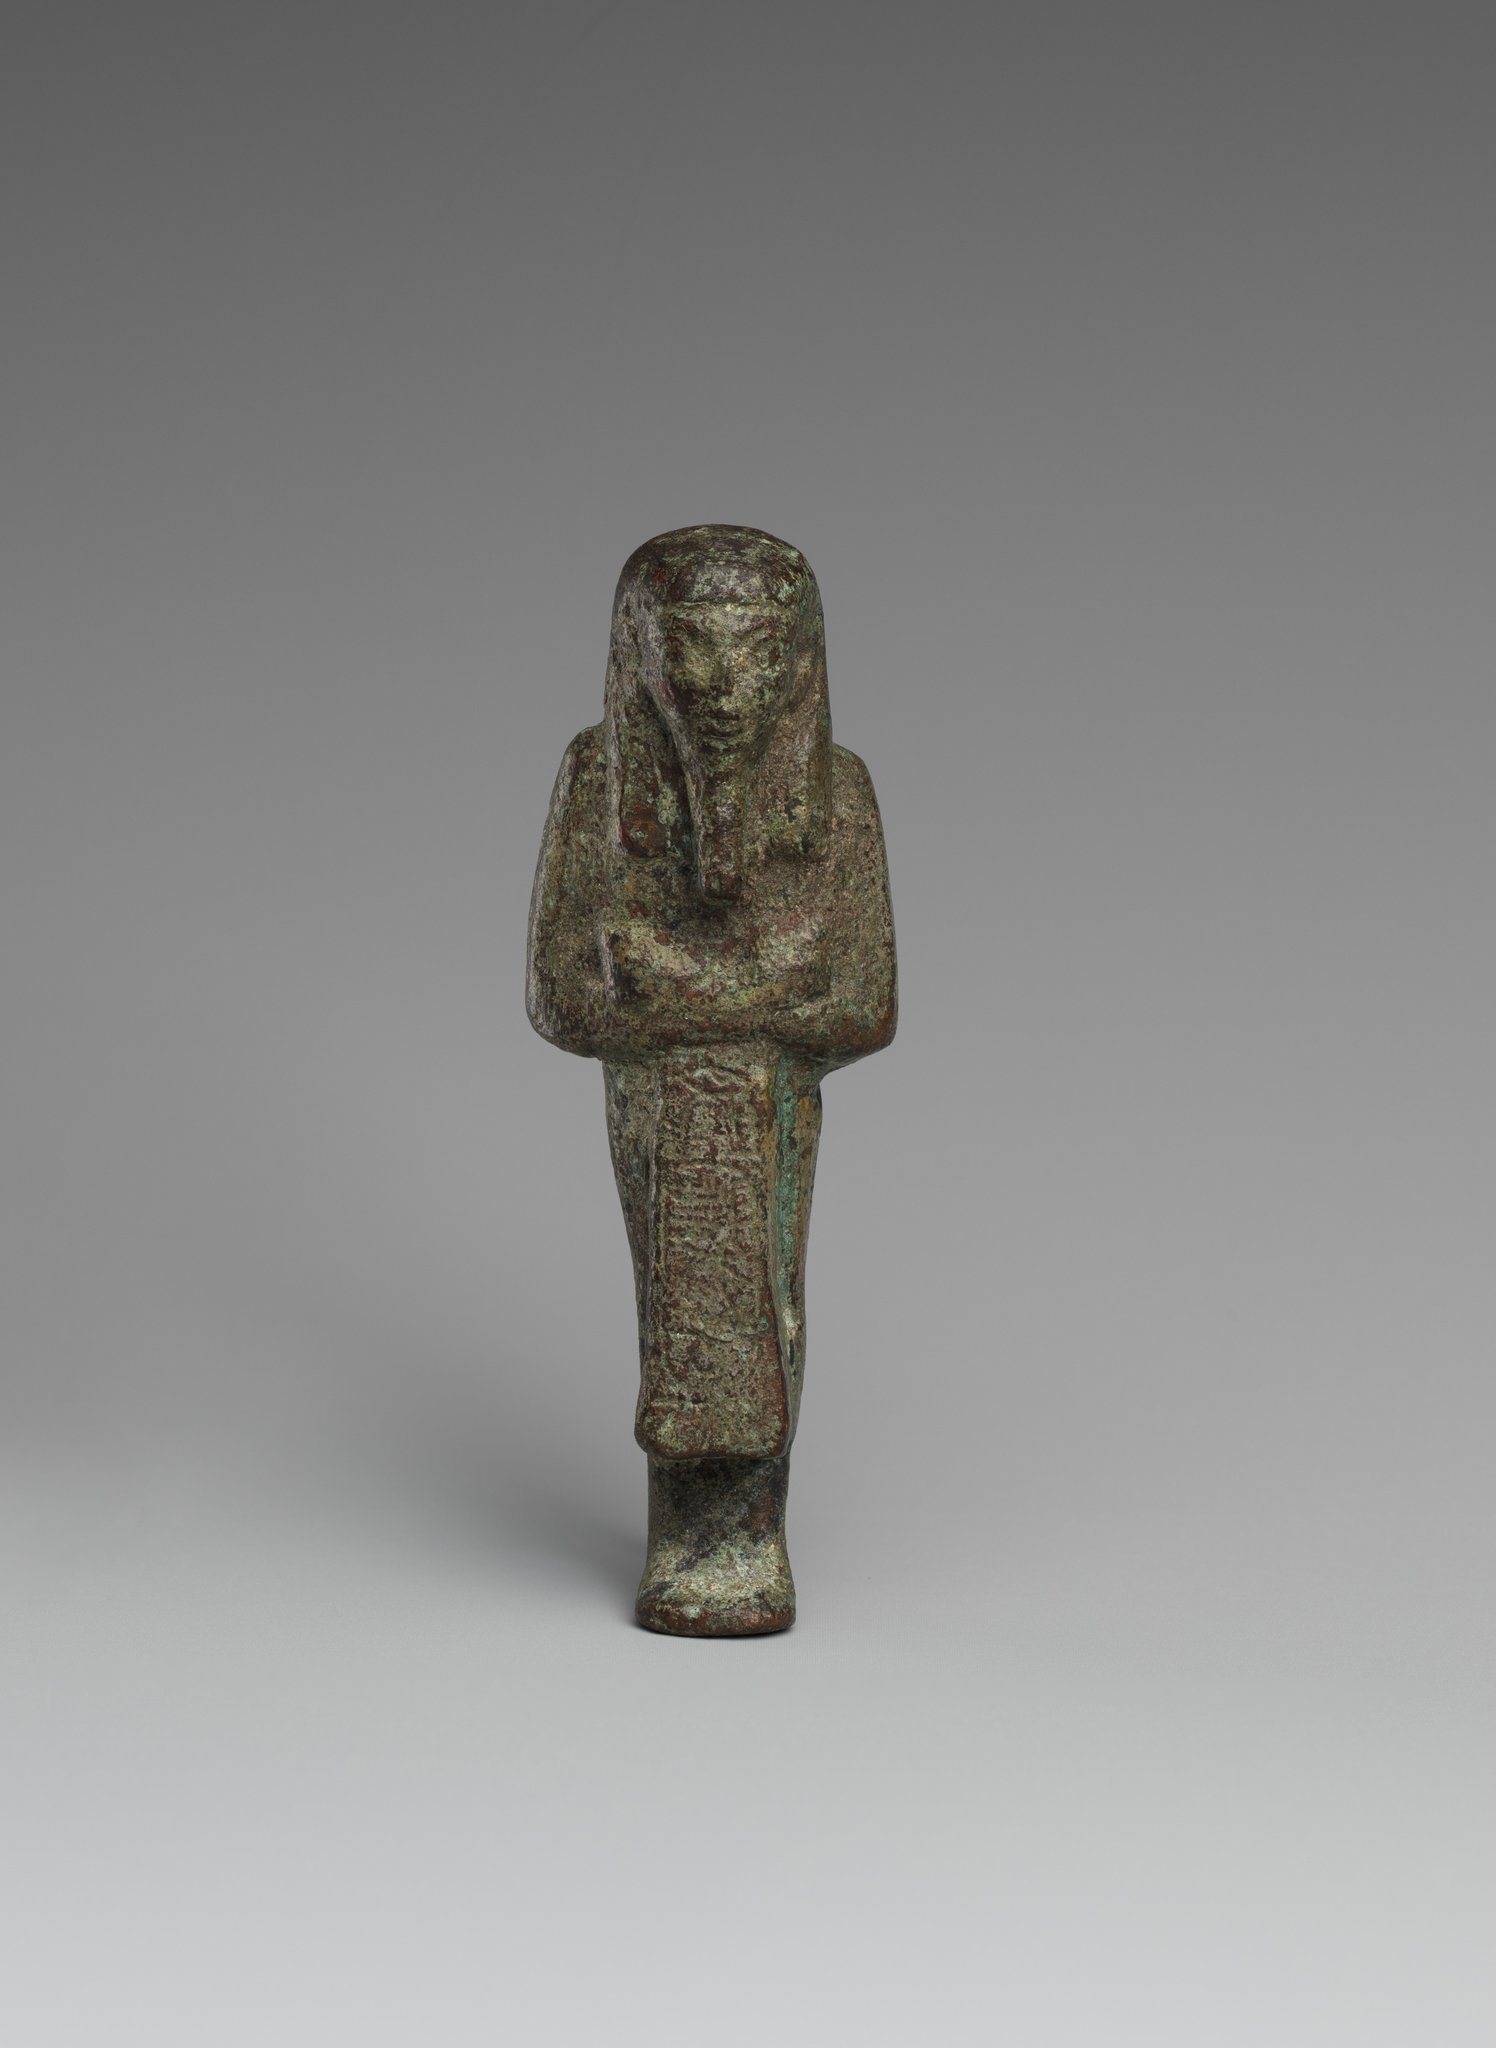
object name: shabti, psusennes i, overseer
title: Overseer Shabti of Psusennes I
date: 1040-992 BCE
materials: bronze, copper alloy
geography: egypt